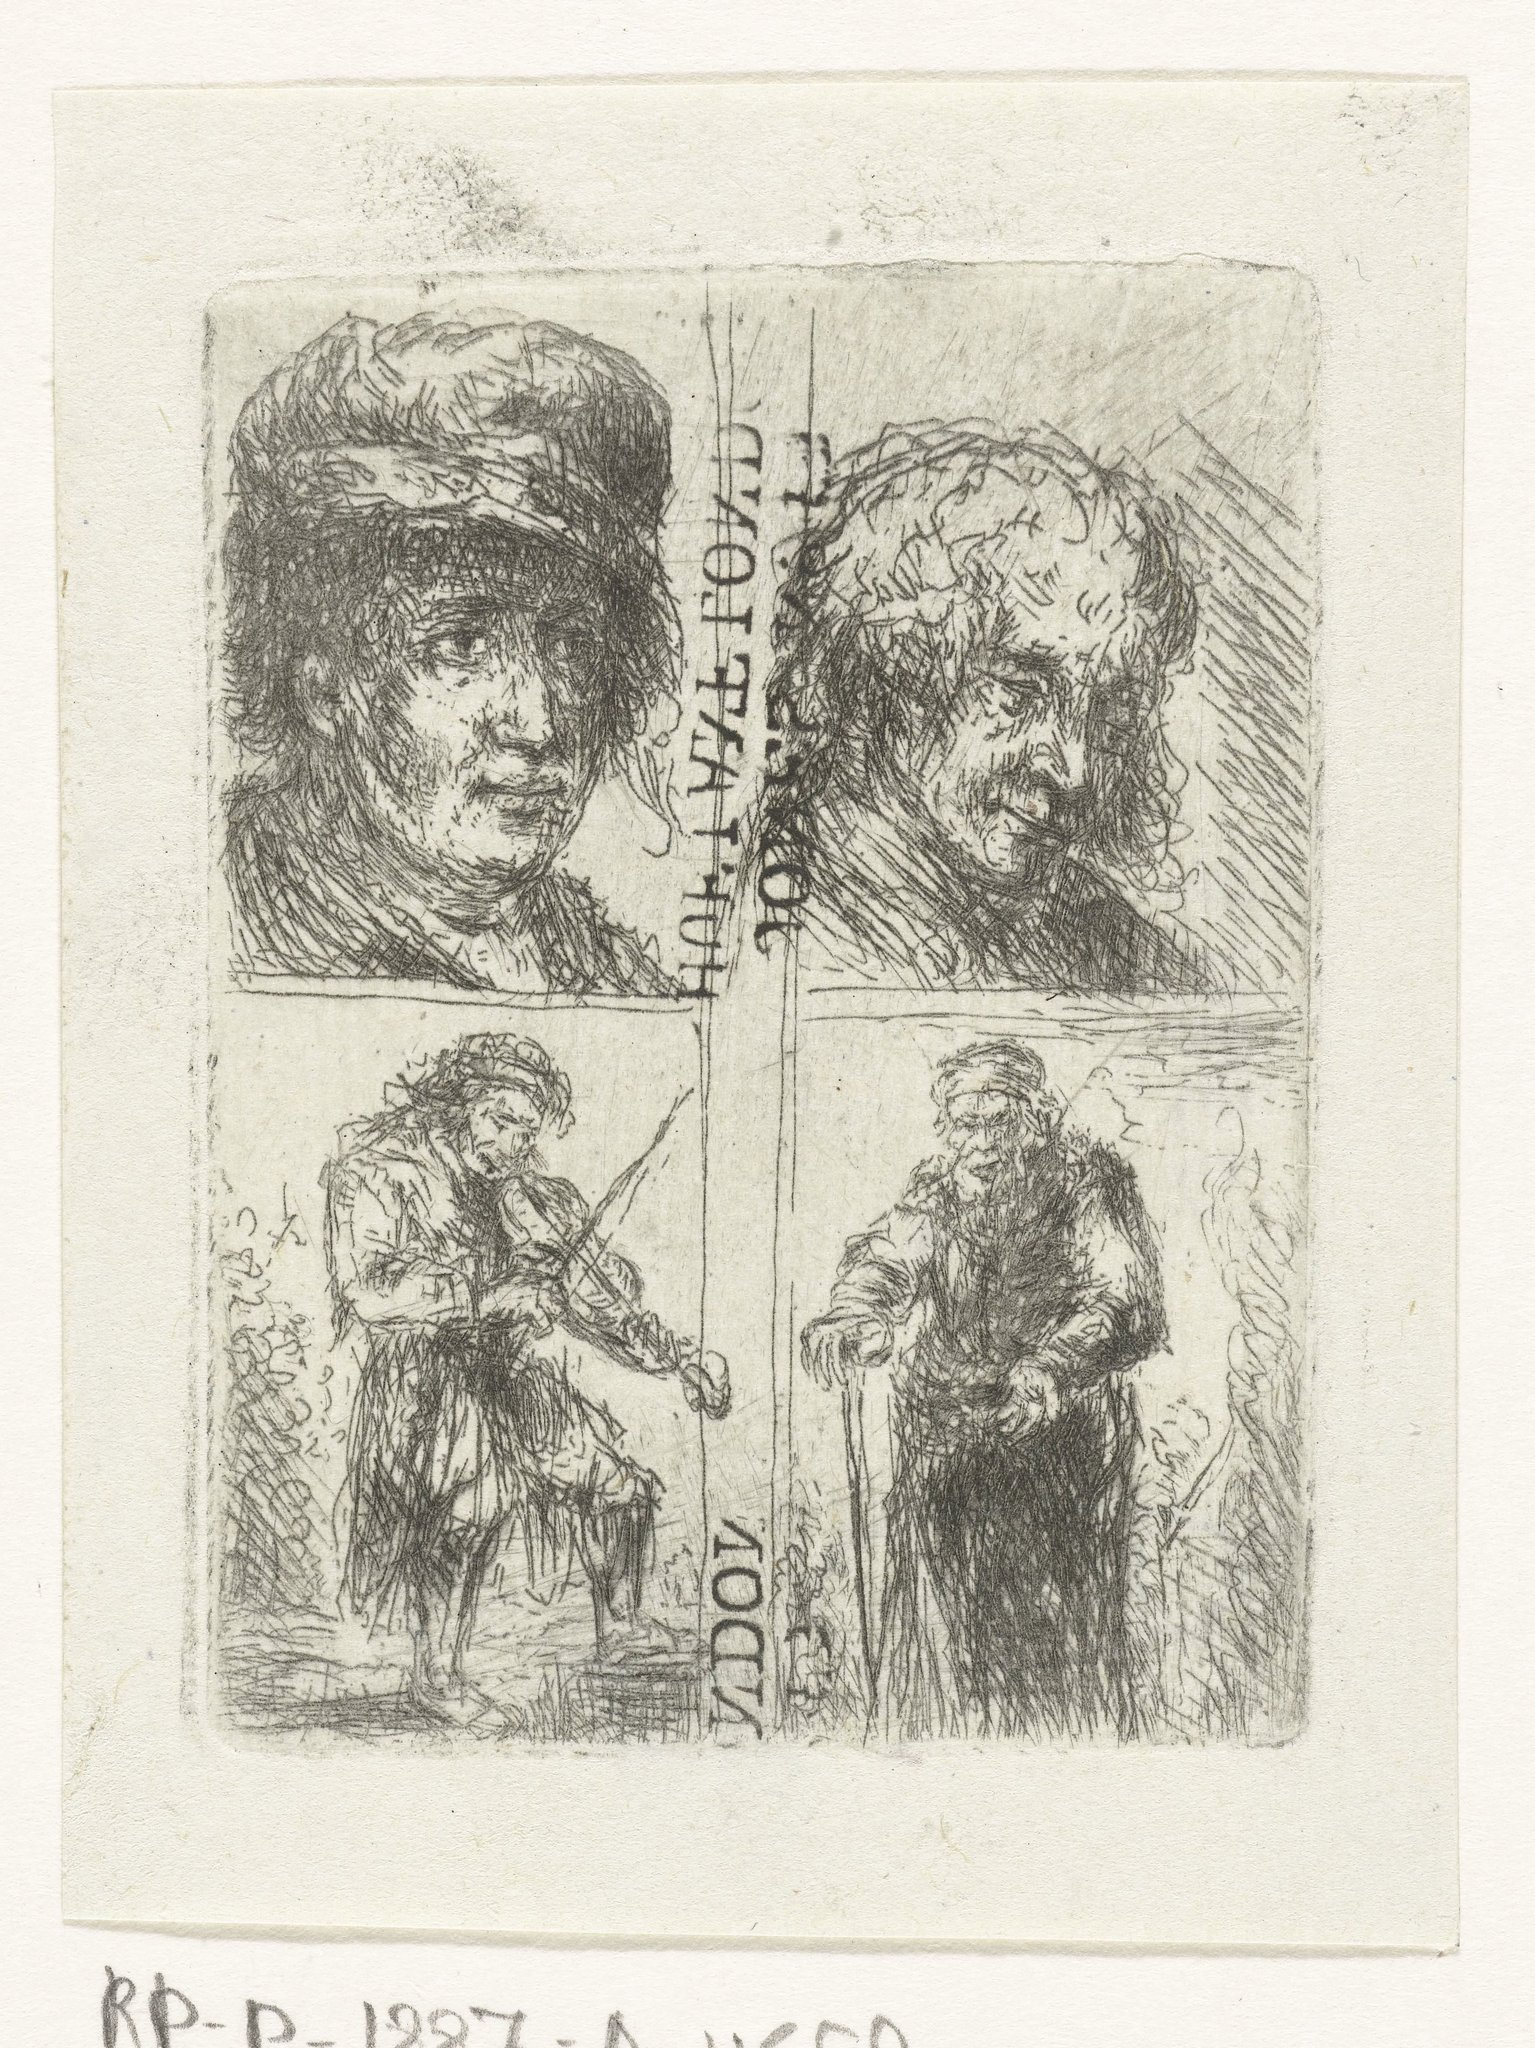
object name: print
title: Vier mannen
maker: jan chalon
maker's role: print maker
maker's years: 1738-1795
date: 1748-1795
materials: paper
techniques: drypoint, etching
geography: northern netherlands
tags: walking-stick, staff, violin, fiddle, morphology of human expression (+ old male (human being)), morphology of human expression (+ adult male (human being))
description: Voorstelling in vier delen. In de bovenste twee delen de bustes van twee mannen. Daaronder speelt een man viool. Rechtsonder een oude man met een wandelstok. In spiegelschrift staat er verticaal wat tekst.